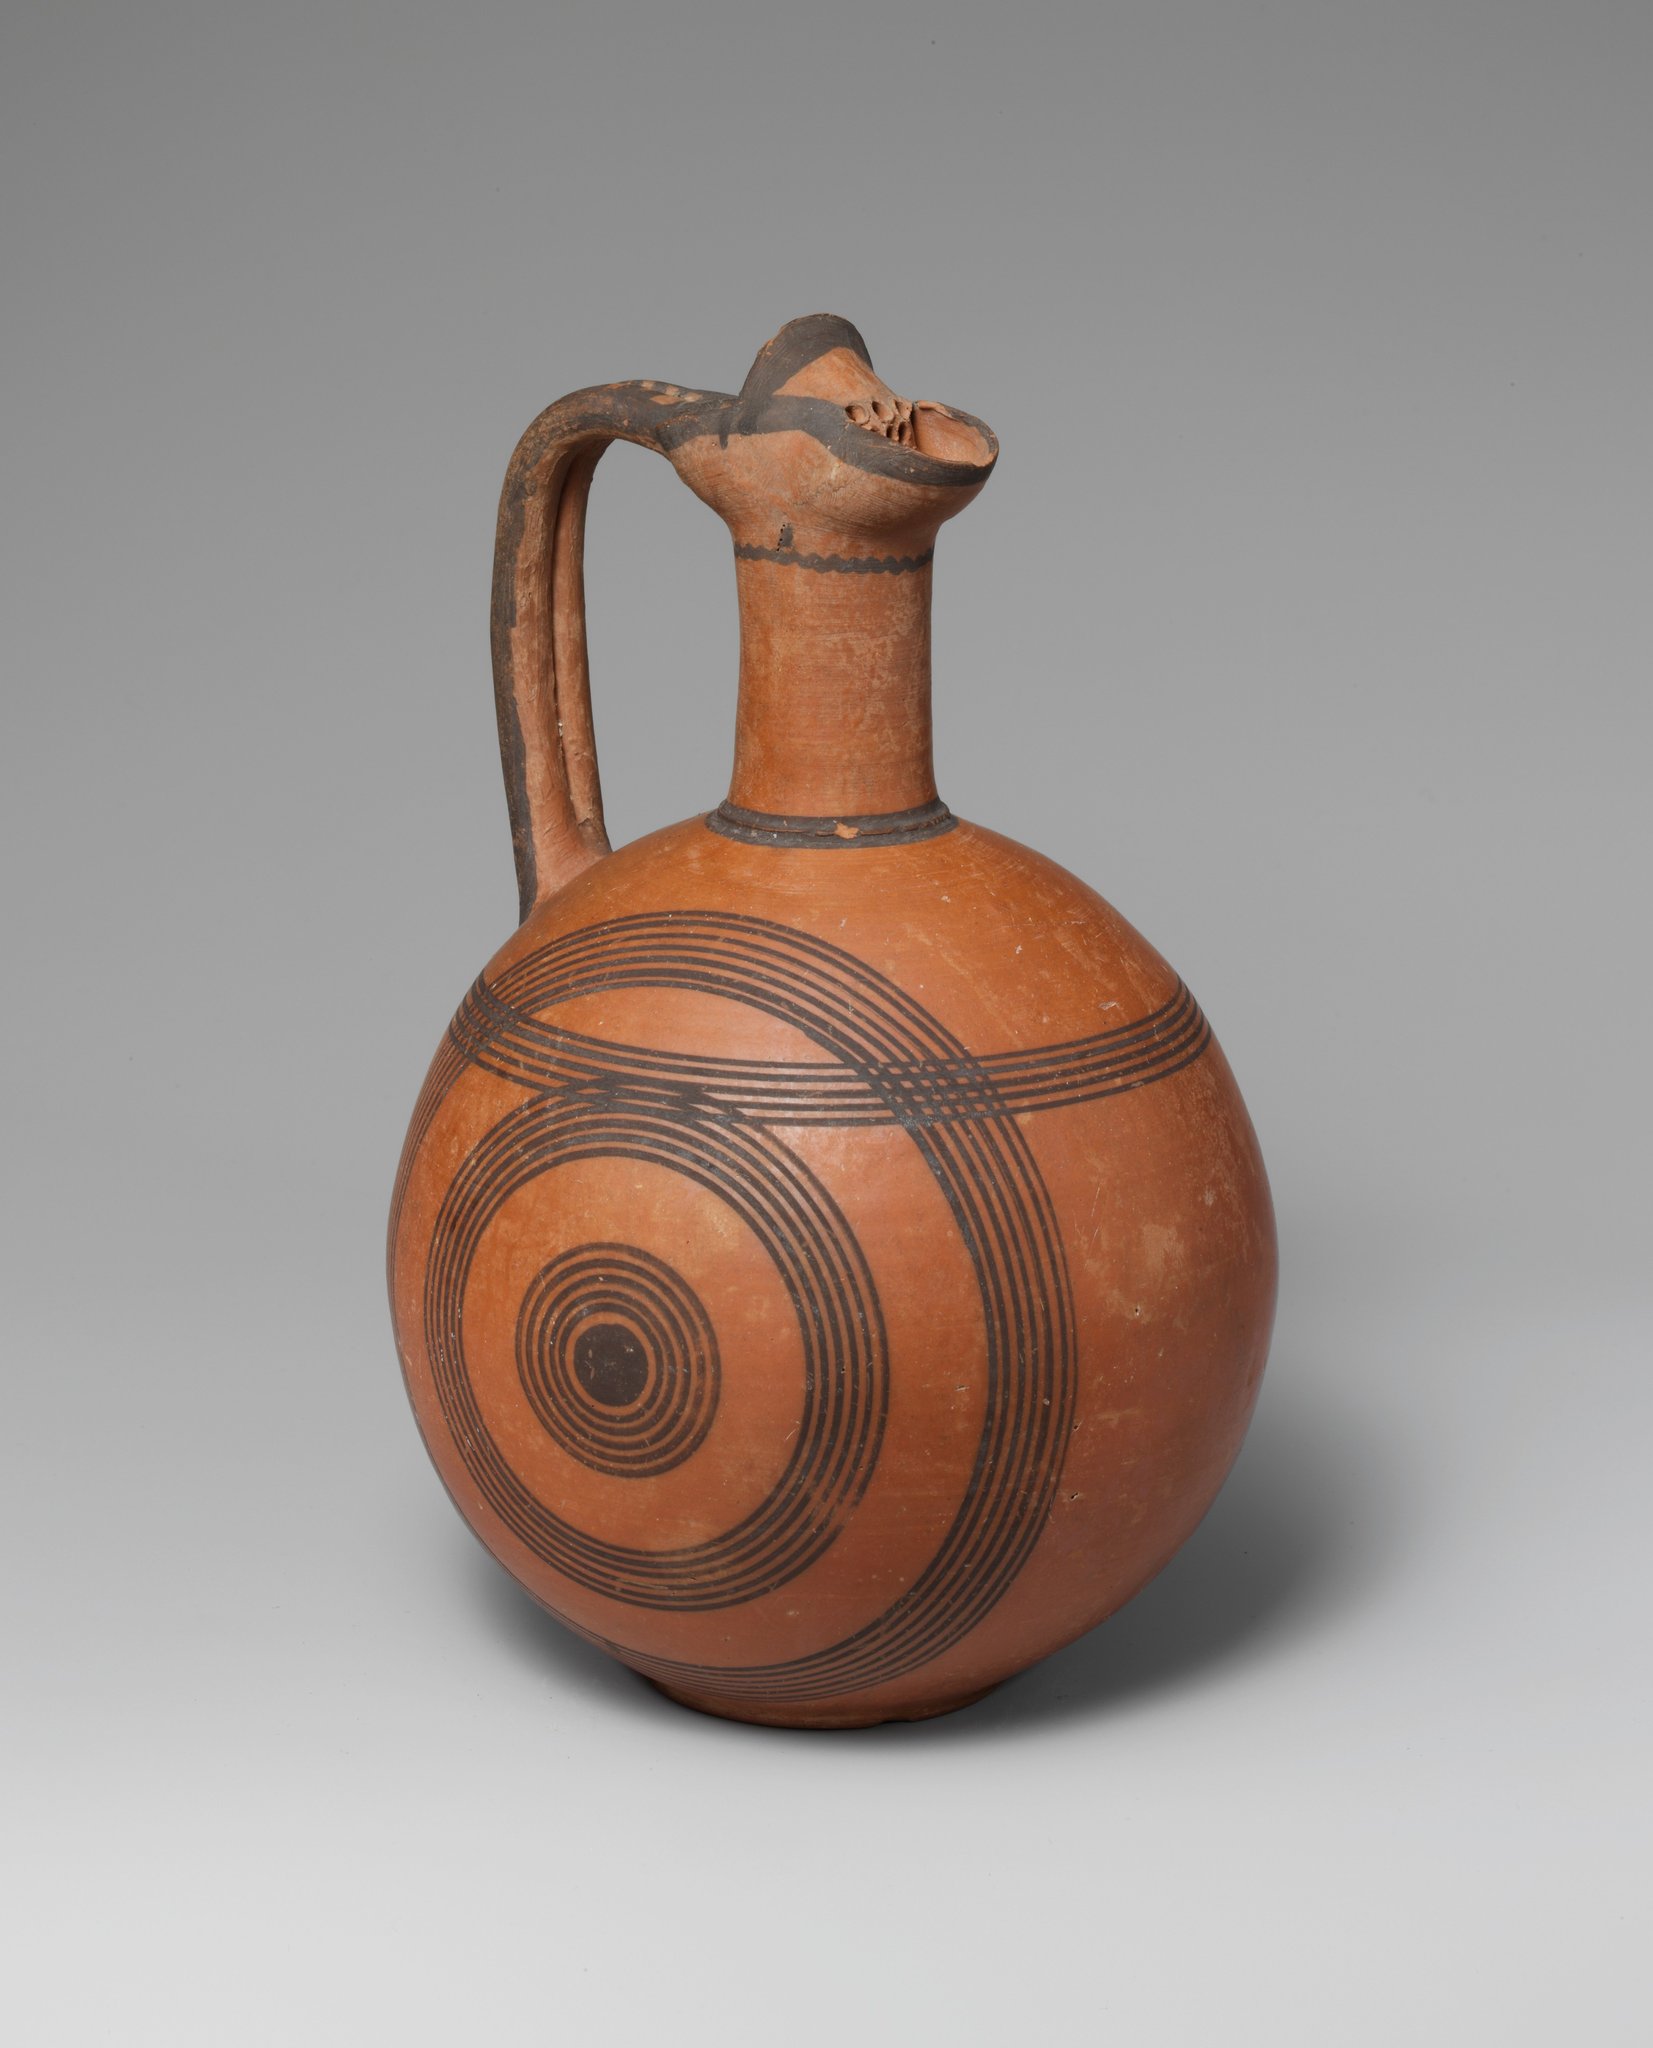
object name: jug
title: Terracotta jug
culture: cypriot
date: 750-600 BCE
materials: terracotta